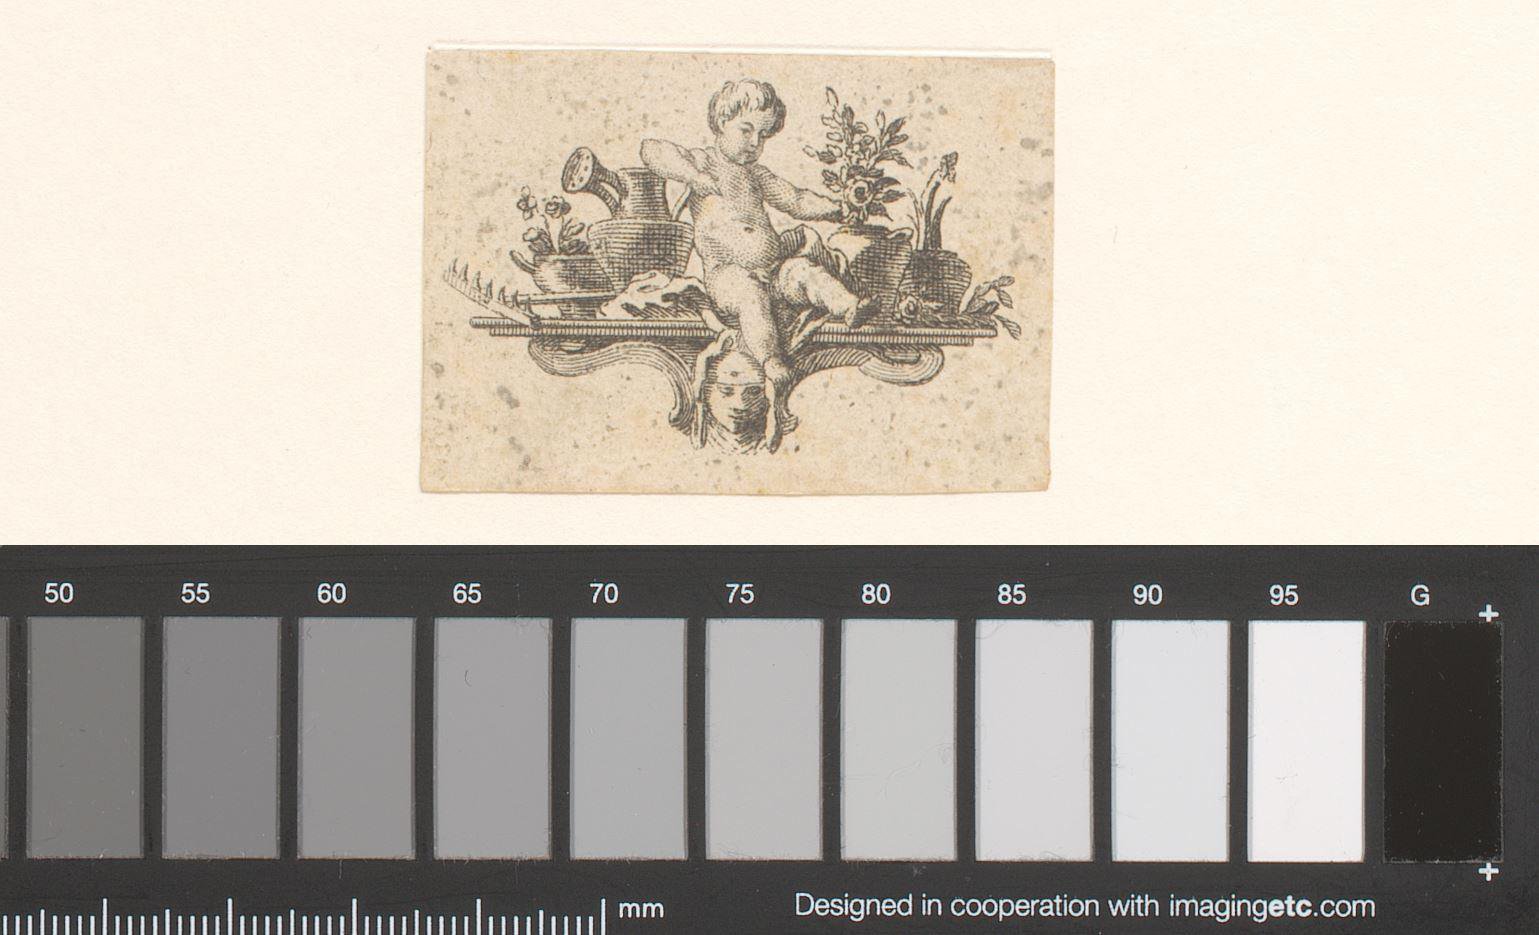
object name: print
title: Vignet met putto tussen gieter, bloempotten en hark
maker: Anonymous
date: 1700-1800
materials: paper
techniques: etching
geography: northern netherlands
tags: cut flowers; nosegay, bunch of flowers, gardening-tools, vignette, cupids: 'amores', 'amoretti', 'putti', garden vase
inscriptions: collector's mark: Lugt 2760, collector's mark: Lugt 2228